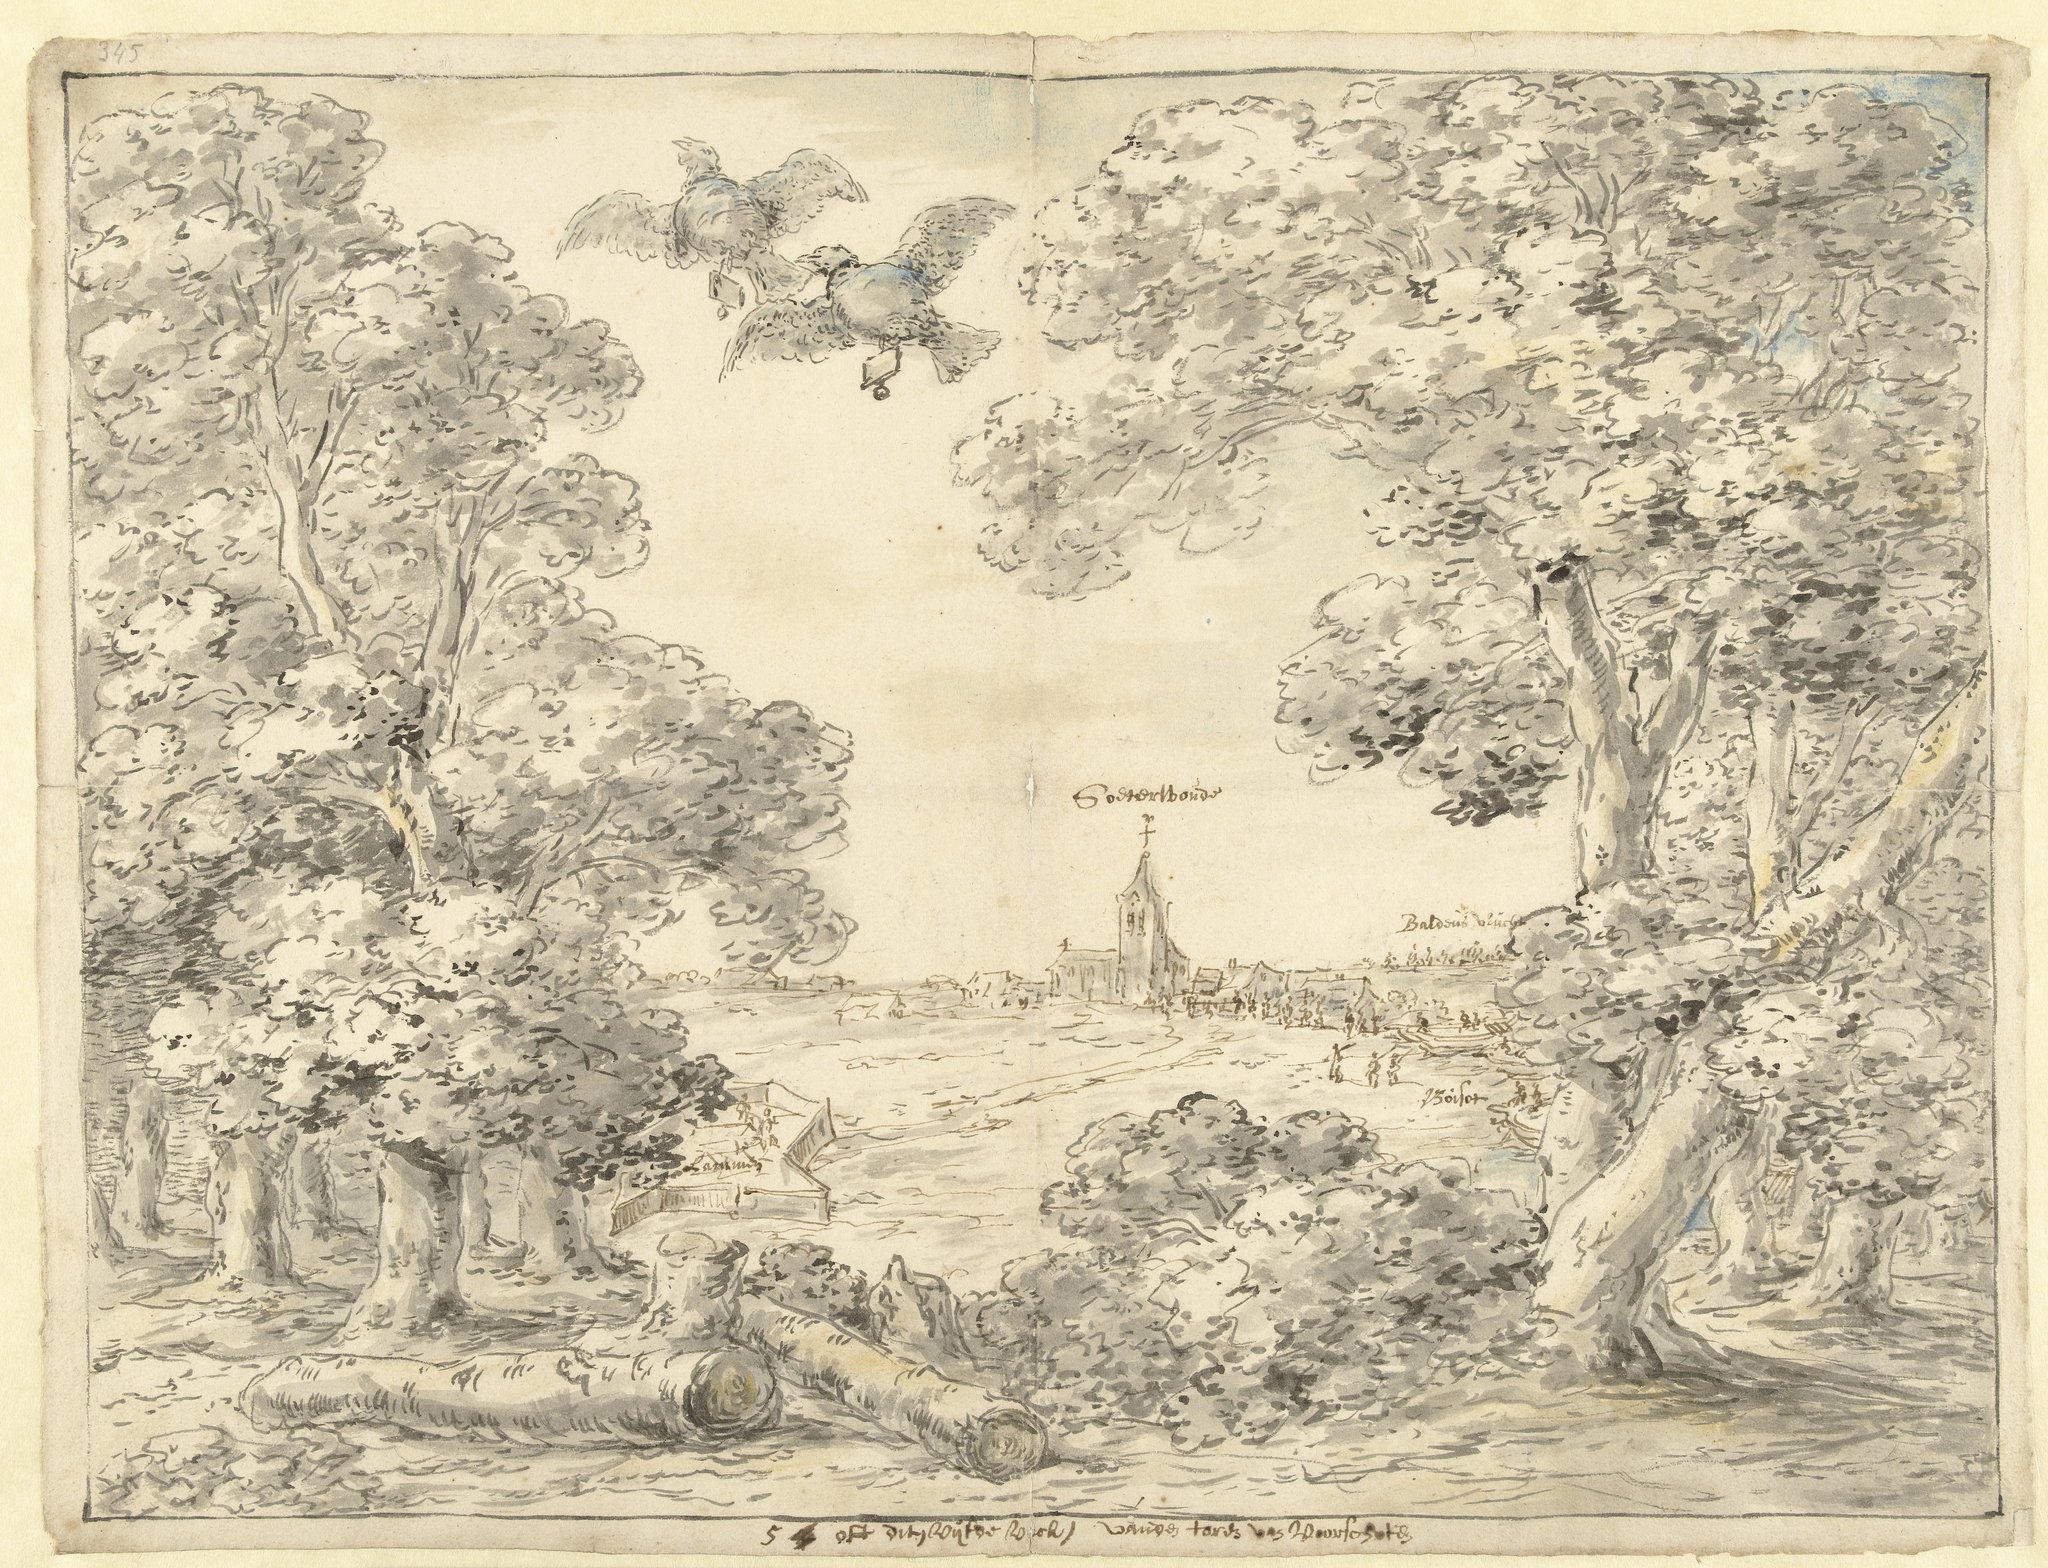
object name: drawing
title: Ontwerpen voor wanddecoraties met gebeurtenissen uit de 80-jarige oorlog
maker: leonaert bramer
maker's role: draughtsman, painter, print maker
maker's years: 1596-1674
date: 1606-1674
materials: ink, paper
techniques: brush, pen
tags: siege, position war, leiden, voorschoten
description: Landschap met een gezicht tussen bomen op Zoeterwoude en de Lammerschans tijdens het beleg van Leiden, 1574. In de lucht vliegen twee postduiven. Ontwerp voor een wanddecoratie.